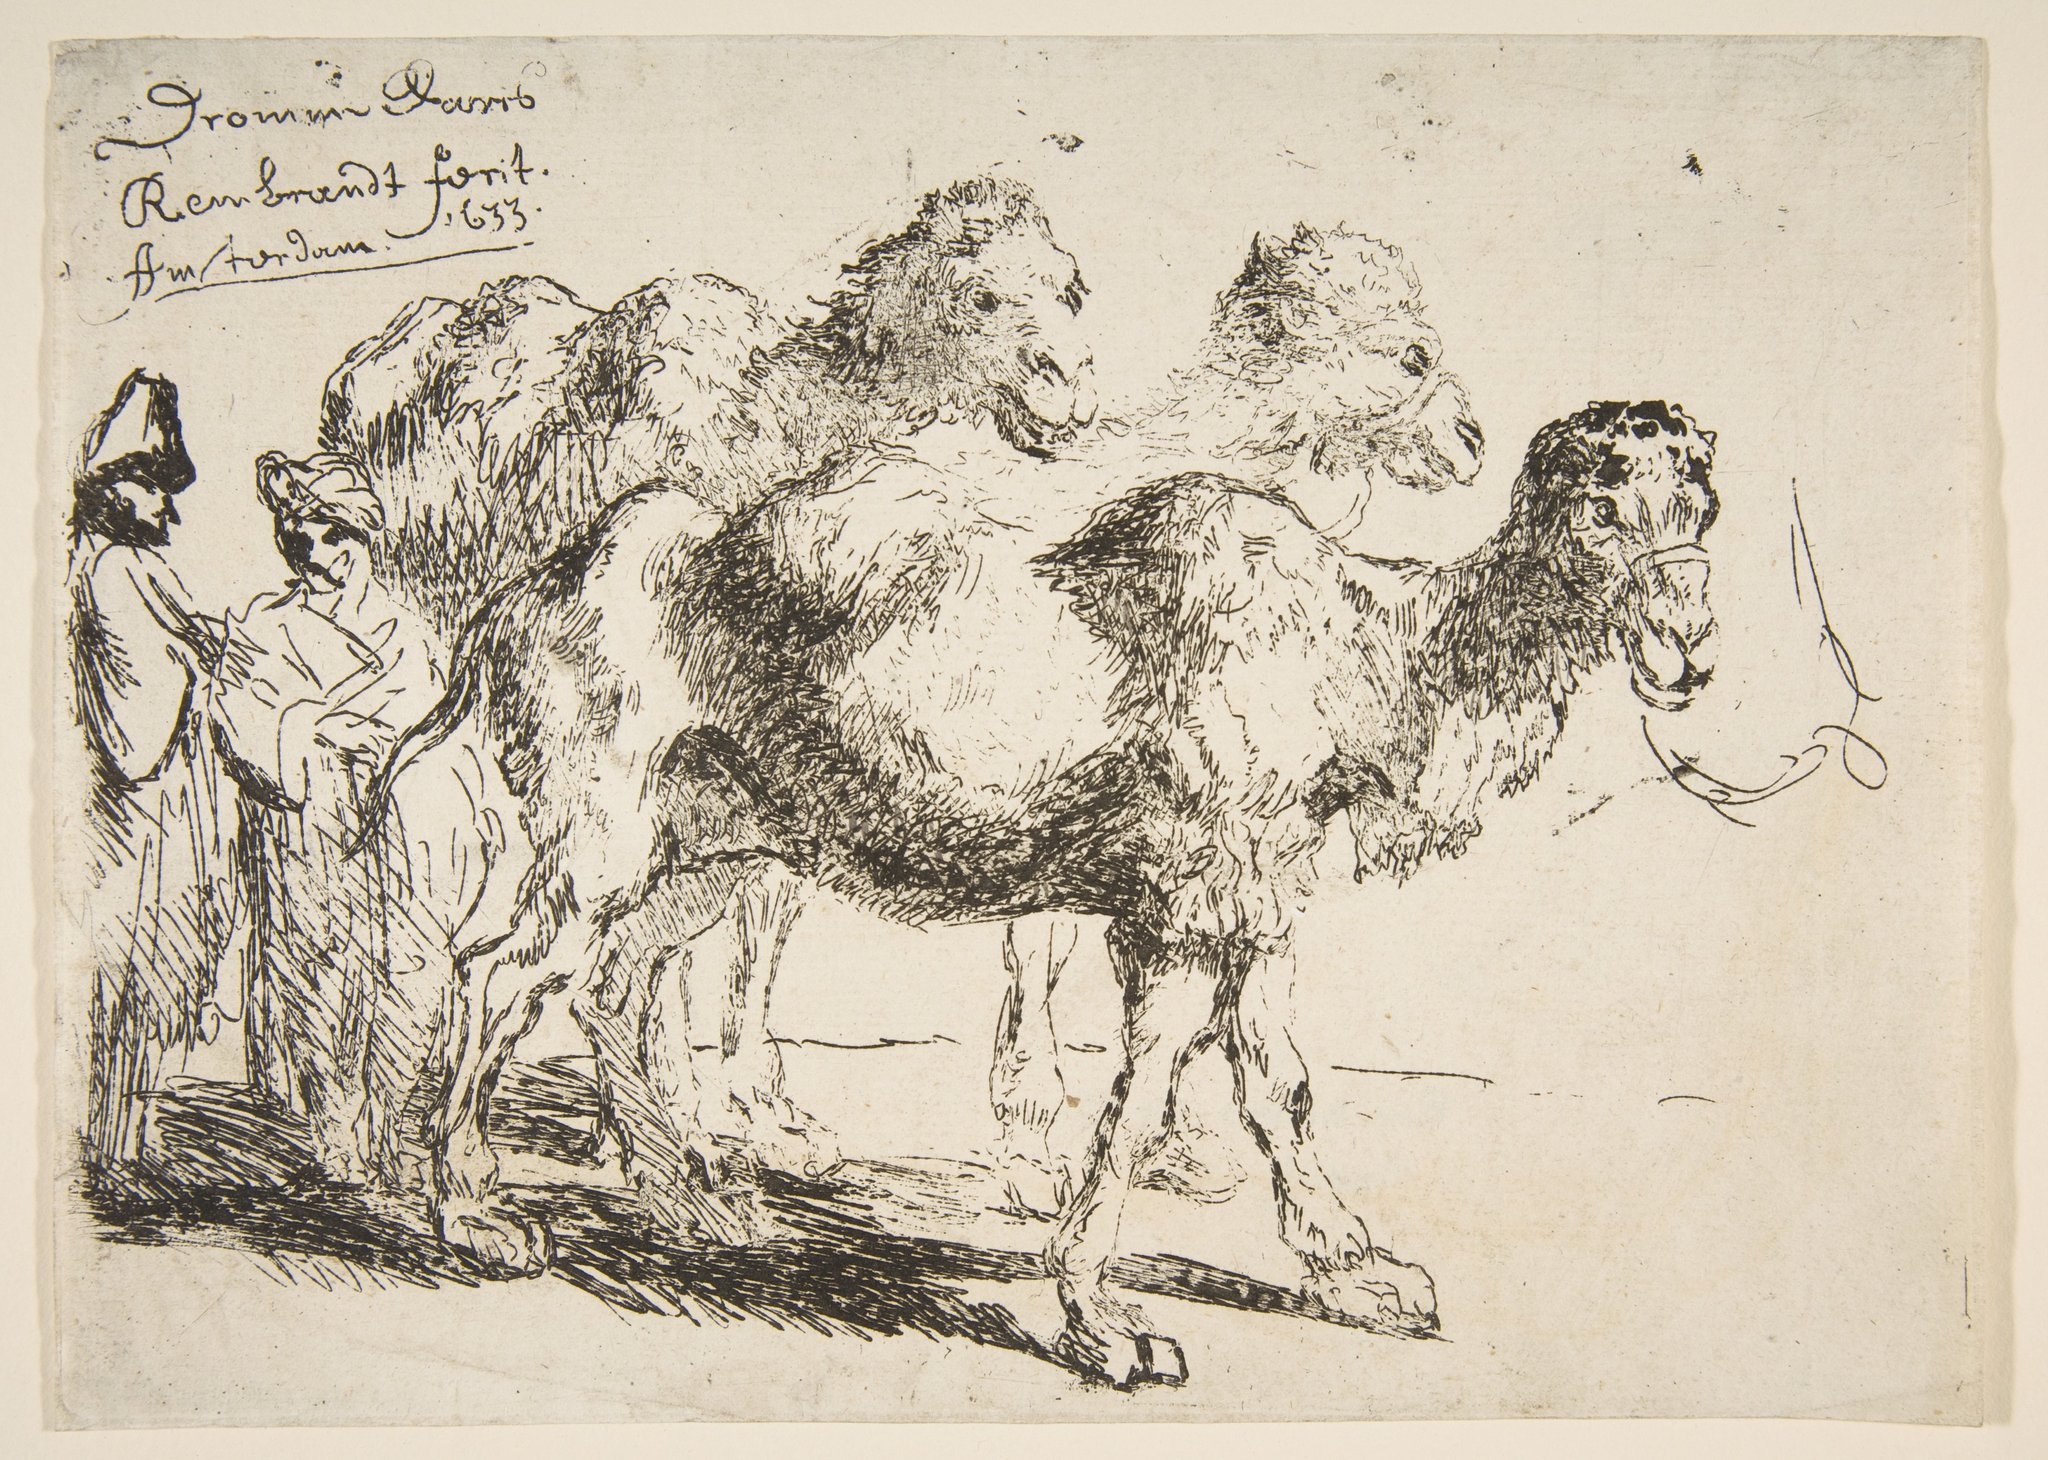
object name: print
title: Three Dromedaries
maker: rembrandt van rijn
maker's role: artist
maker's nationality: dutch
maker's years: 1606-1669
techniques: etching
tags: men,camels